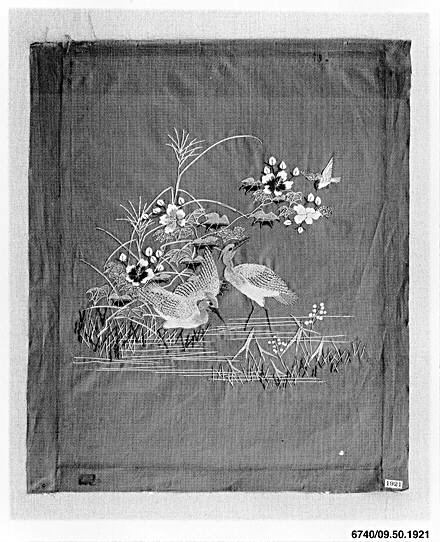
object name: gift cloth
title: Gift Cloth (Fukusa)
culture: japanese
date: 1801-1900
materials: silk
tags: birds,flowers